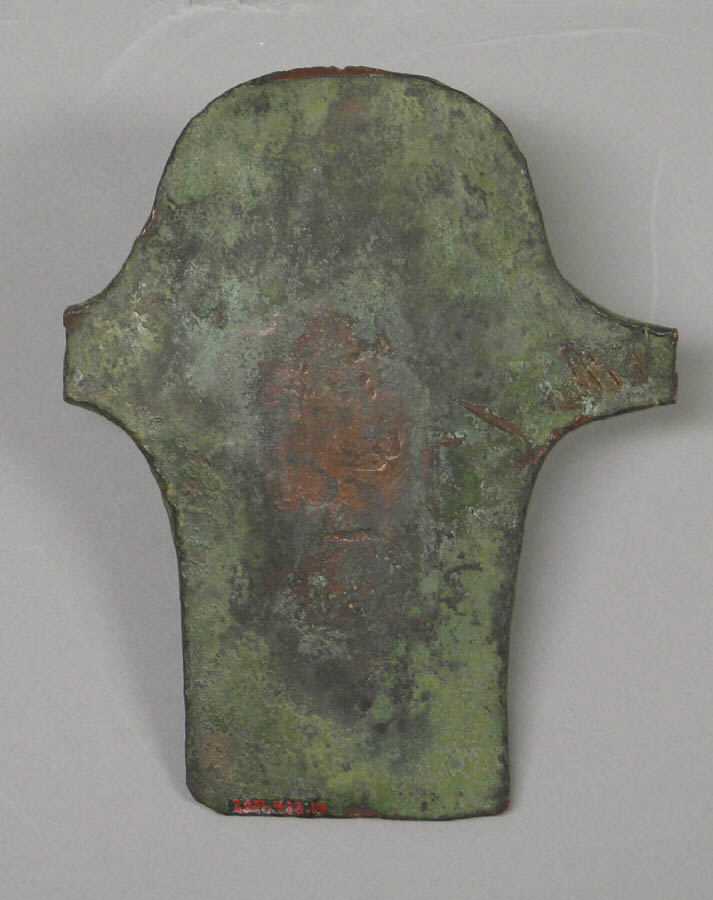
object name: anthropomorph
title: Eccentric Anthropomorph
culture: indian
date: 1500-500 BCE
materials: copper